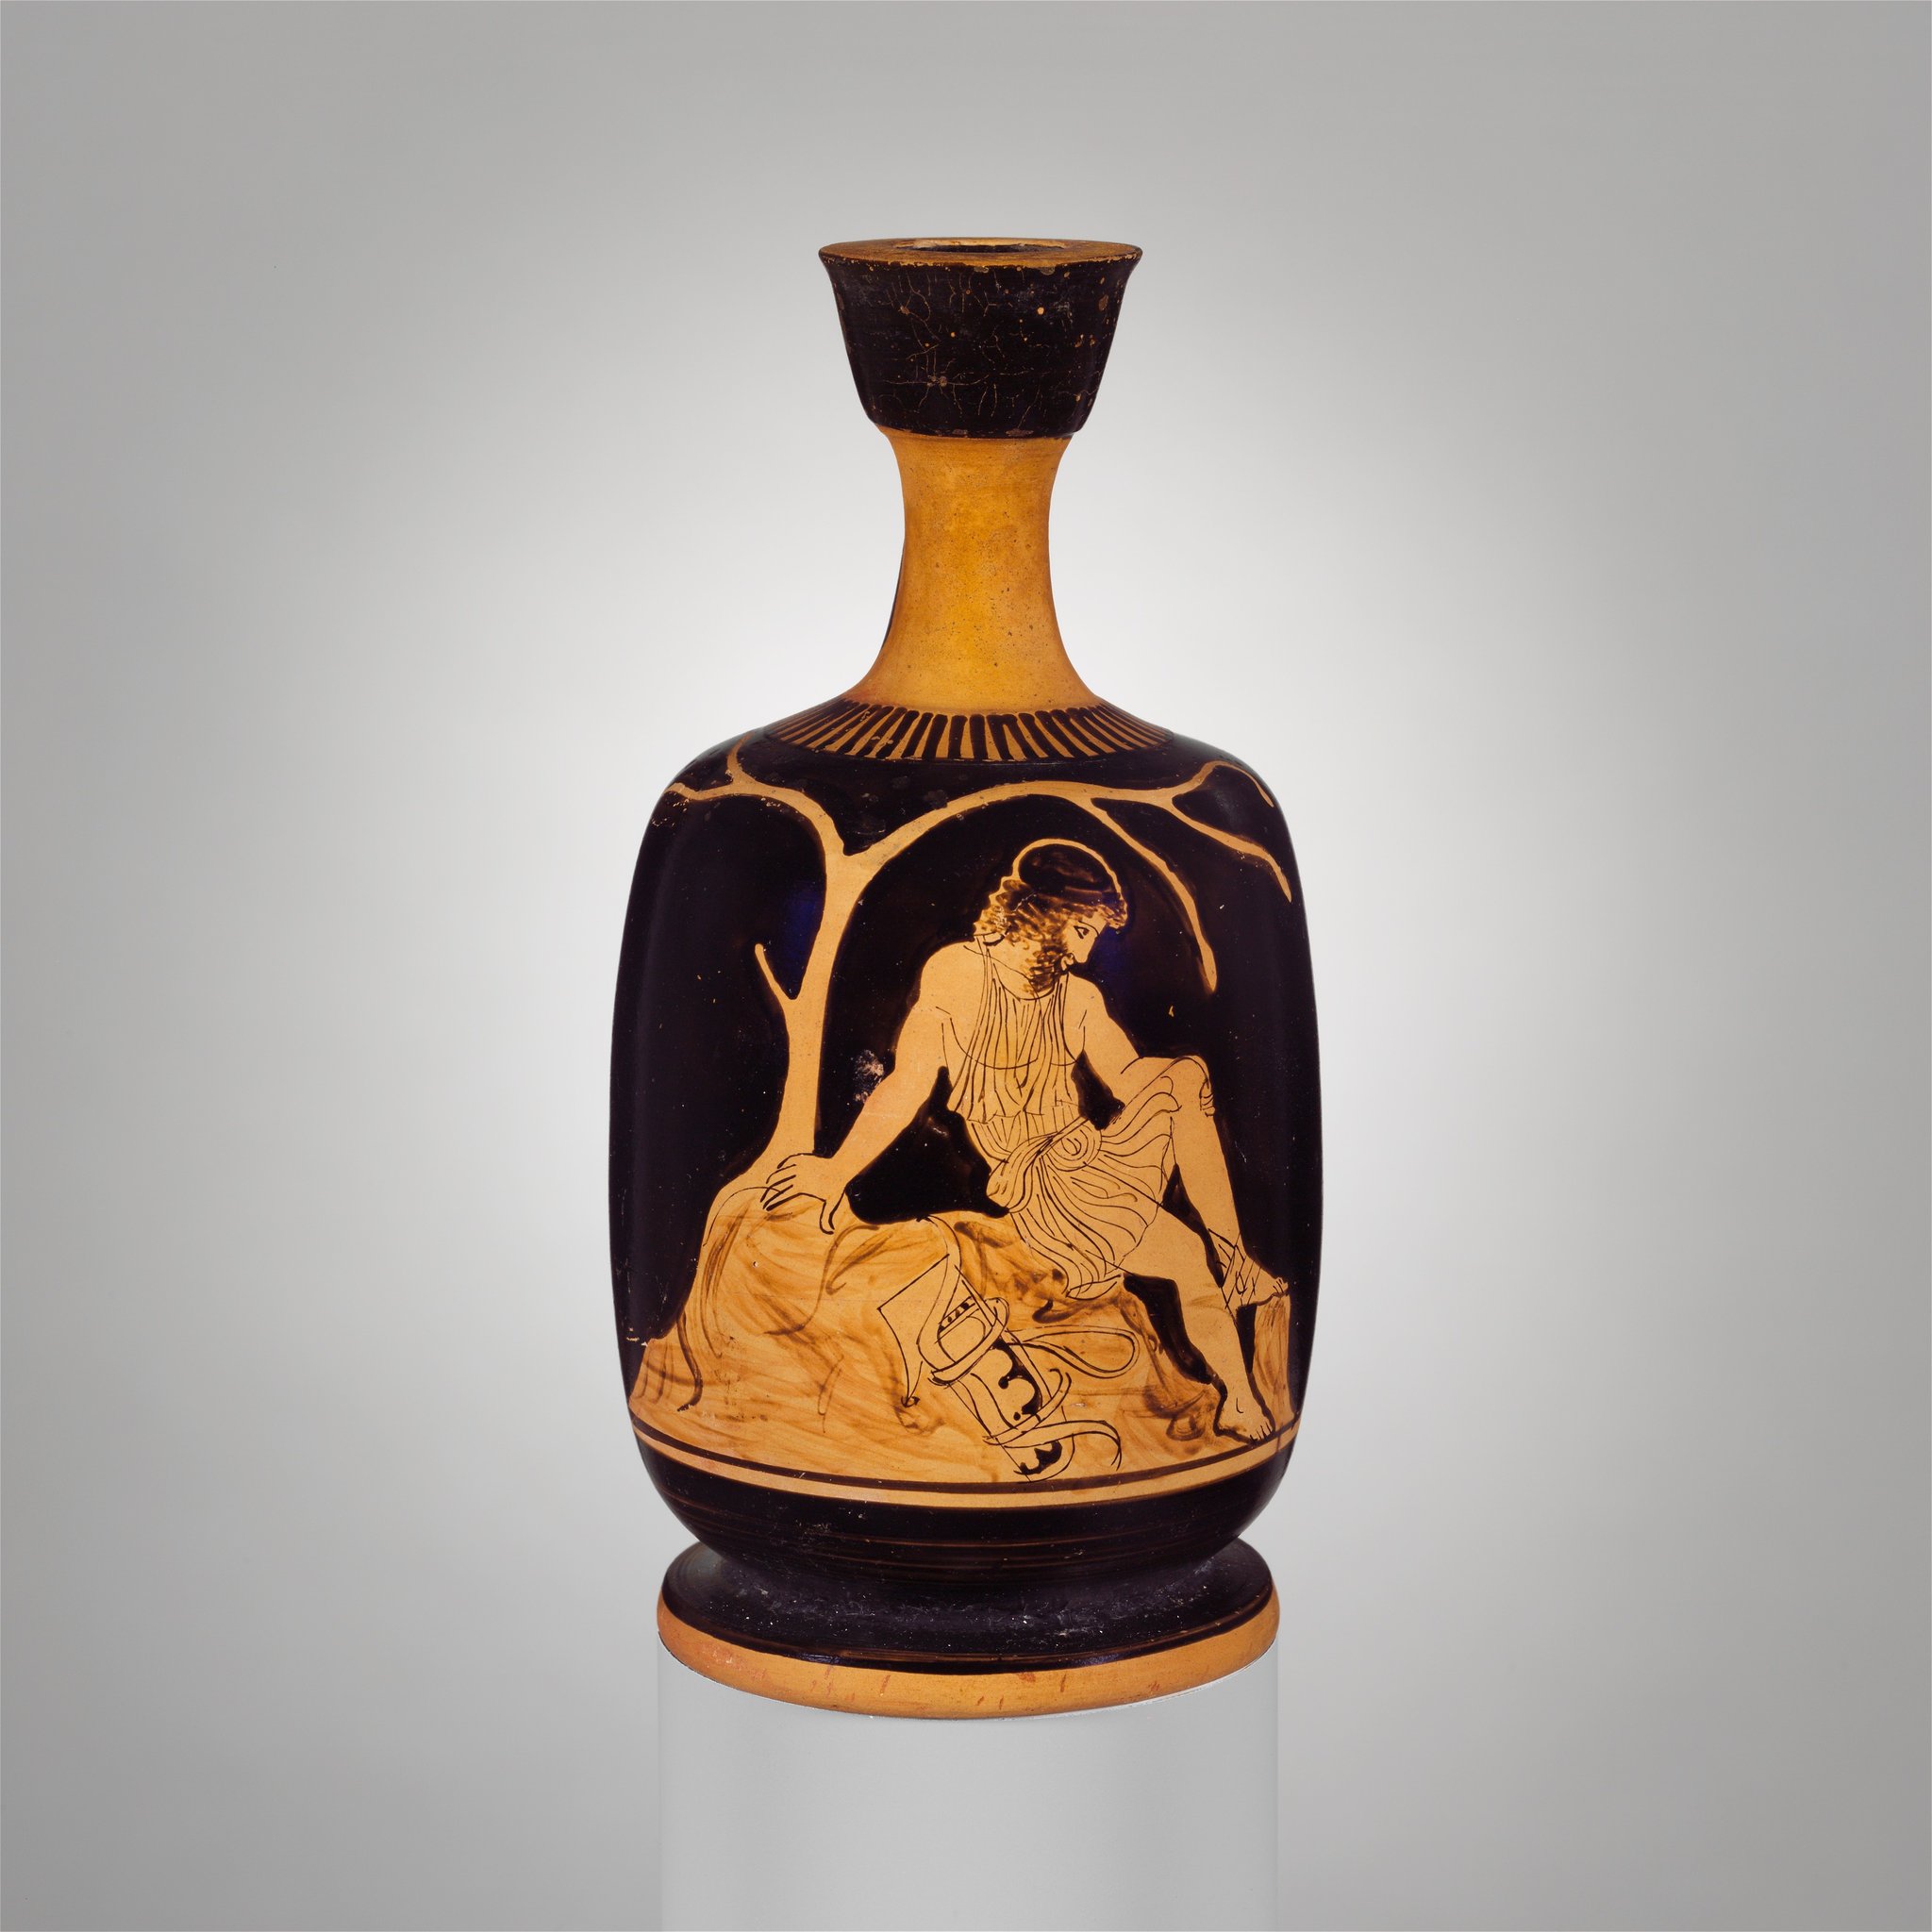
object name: squat lekythos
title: Terracotta squat lekythos (oil flask)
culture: greek, attic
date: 420 BCE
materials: terracotta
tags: trojan war,men